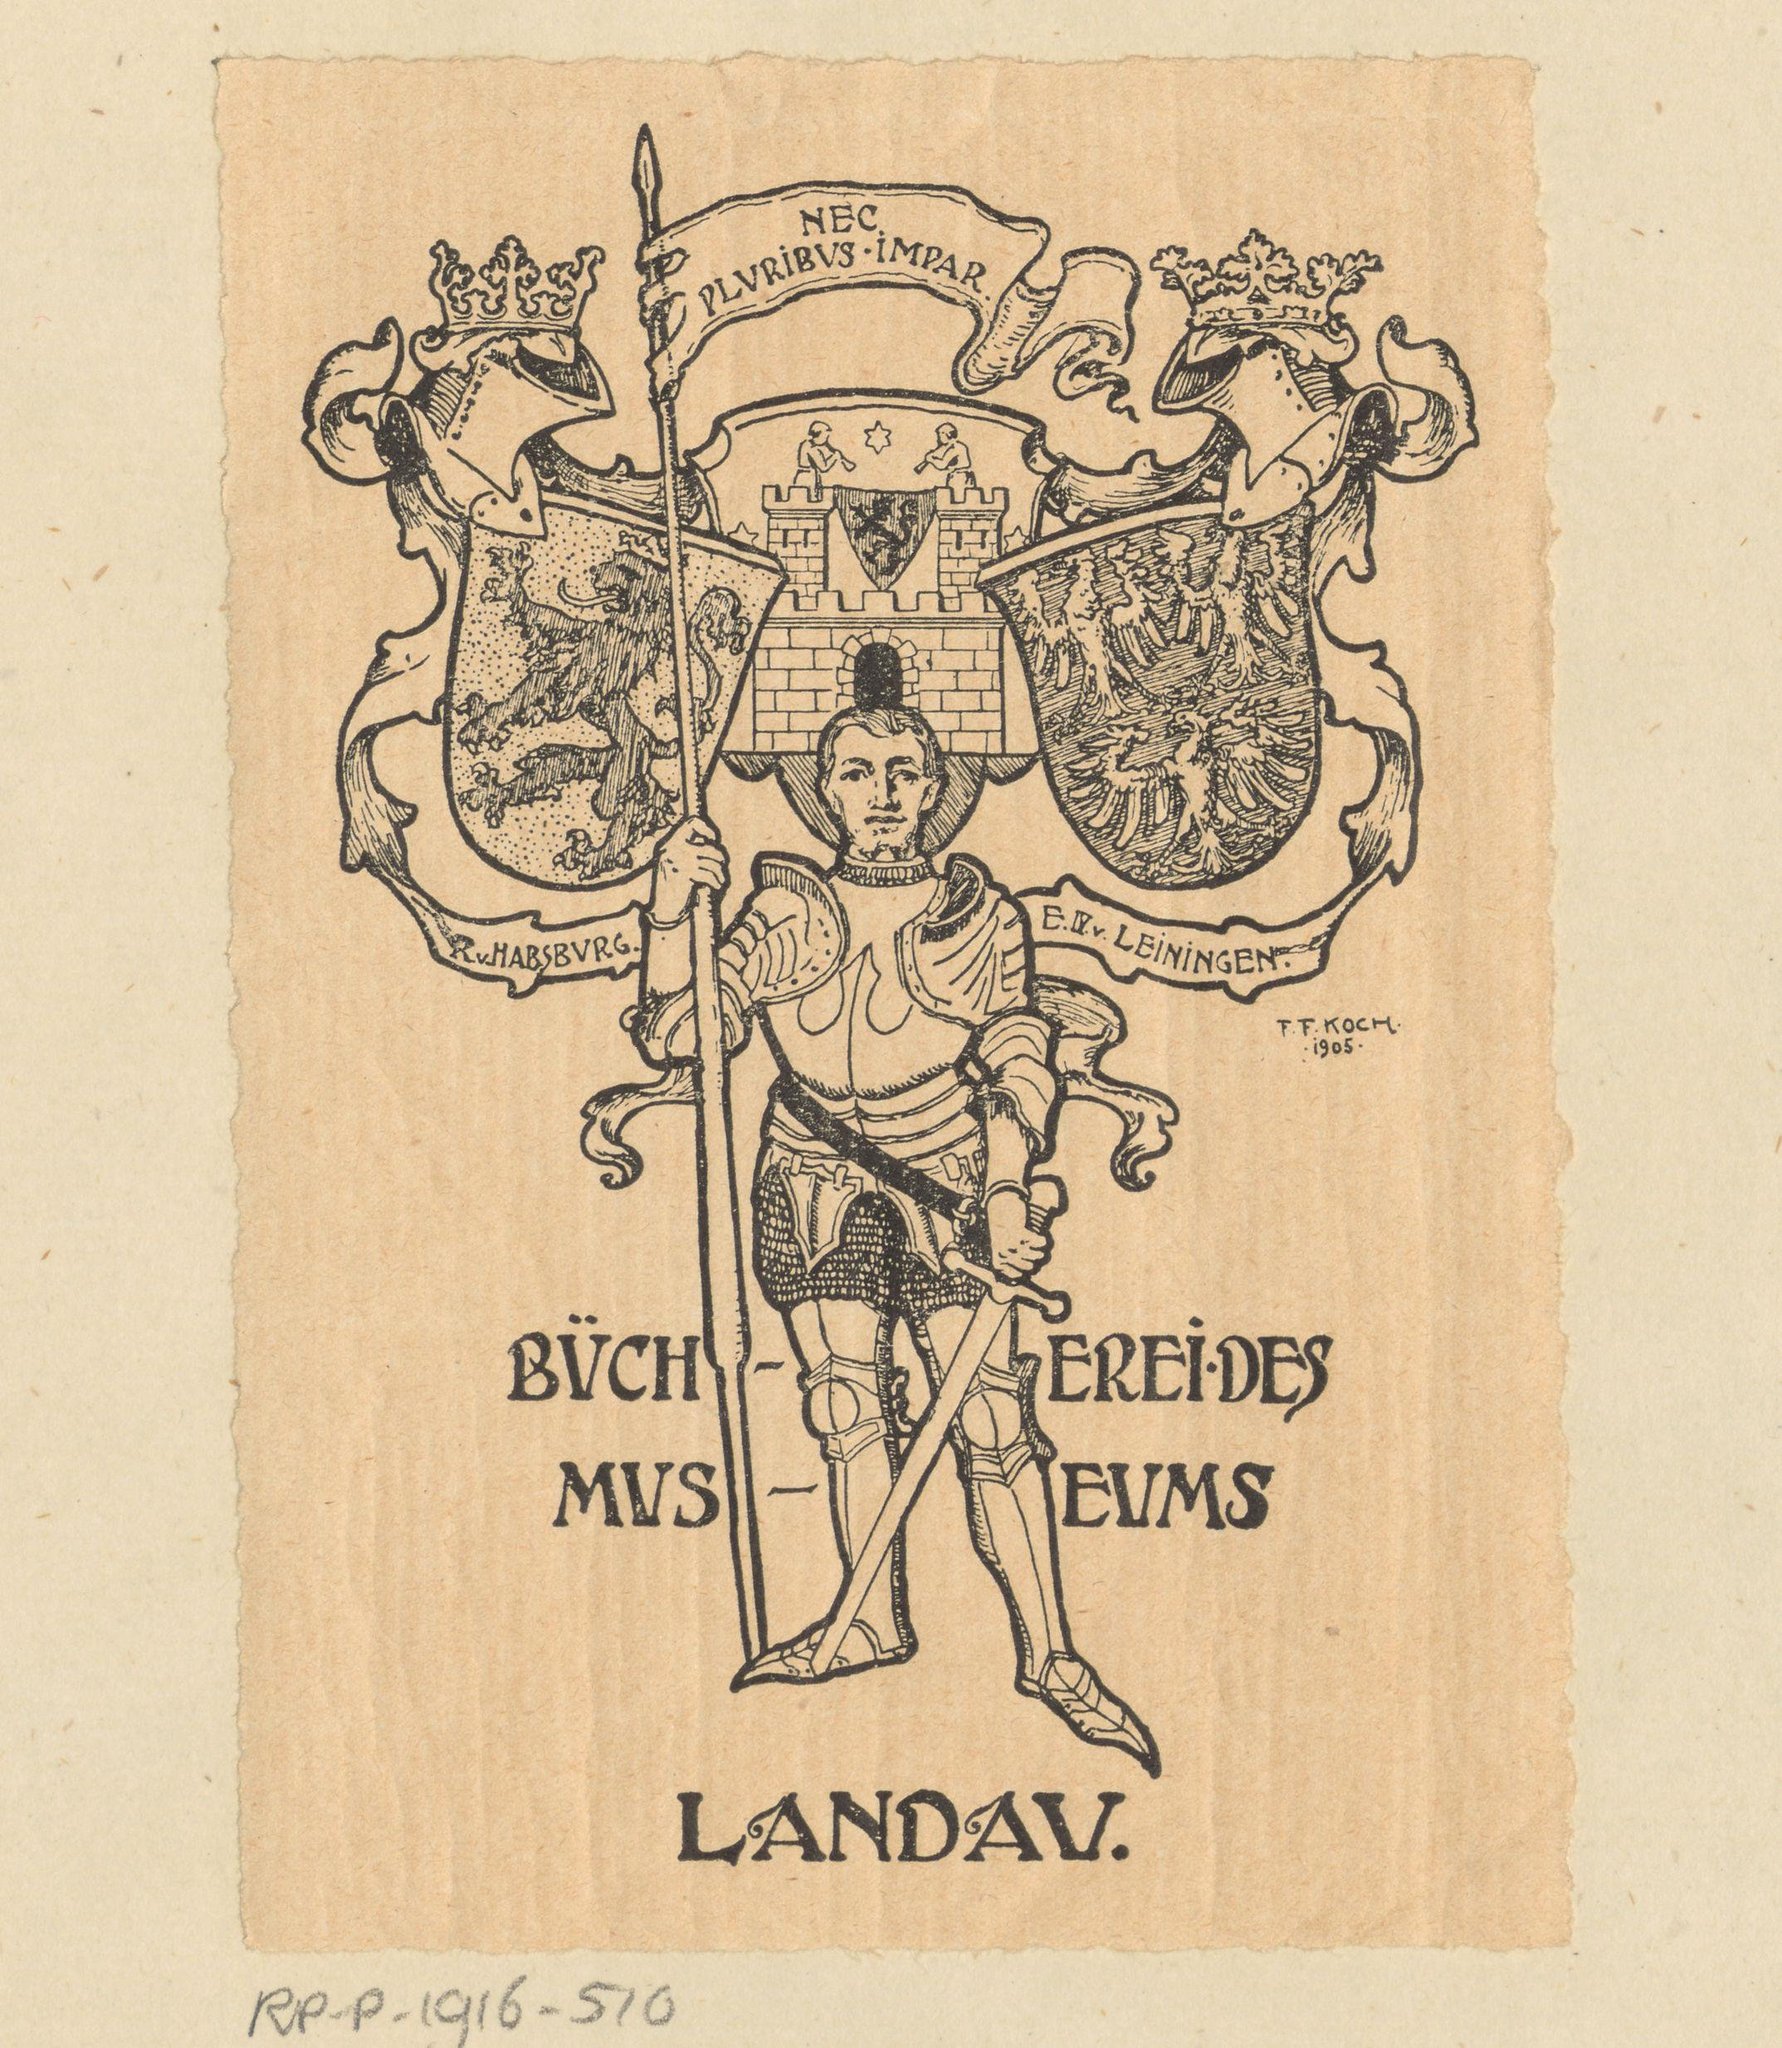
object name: bookplate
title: Bücherei des Museums Landau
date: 1905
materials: paper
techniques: printing block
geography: germany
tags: standing figure, armour, armorial bearing, heraldry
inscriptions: collector's mark: Lugt 2233